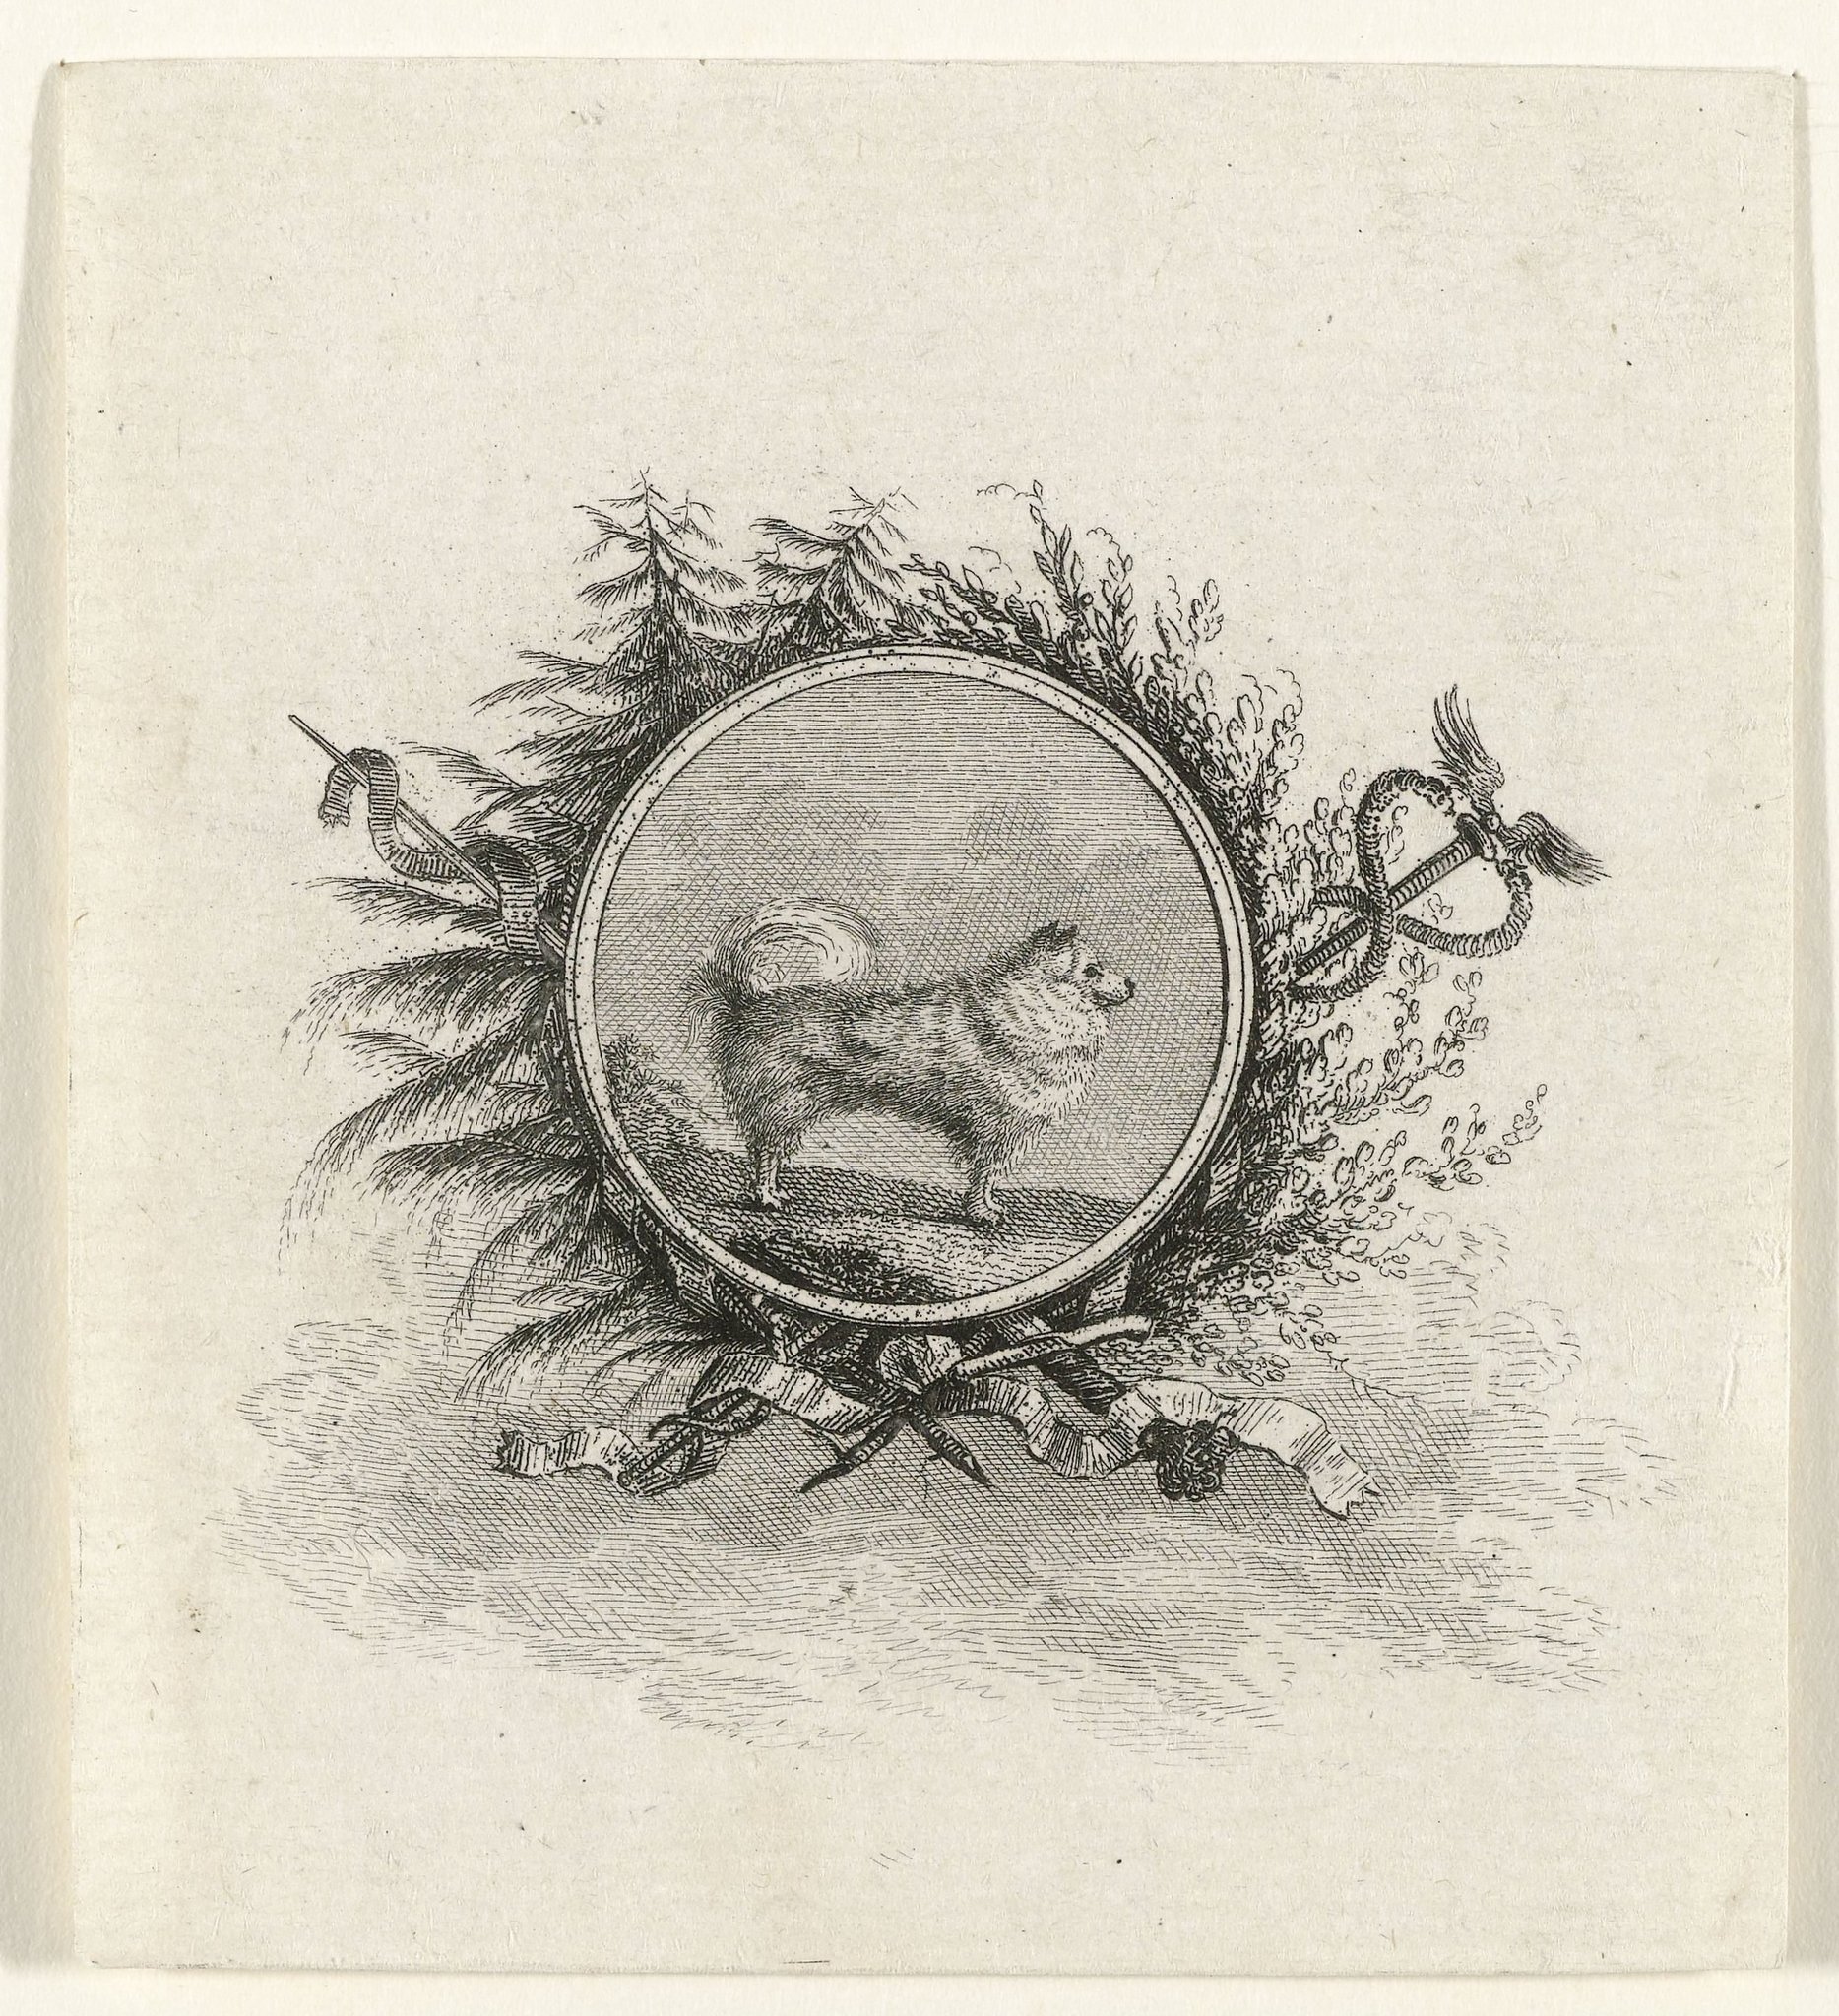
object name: print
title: Medaillon met Keeshond, ca. 1787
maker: Anonymous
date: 1787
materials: paper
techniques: etching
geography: northern netherlands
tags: dog, patriots (1780-1795)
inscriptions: collector's mark: Lugt 2228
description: Medaillon met Keeshond, ca. 1787. Om het medaillon dennentakken, een zwaard met linten en een esculaap.